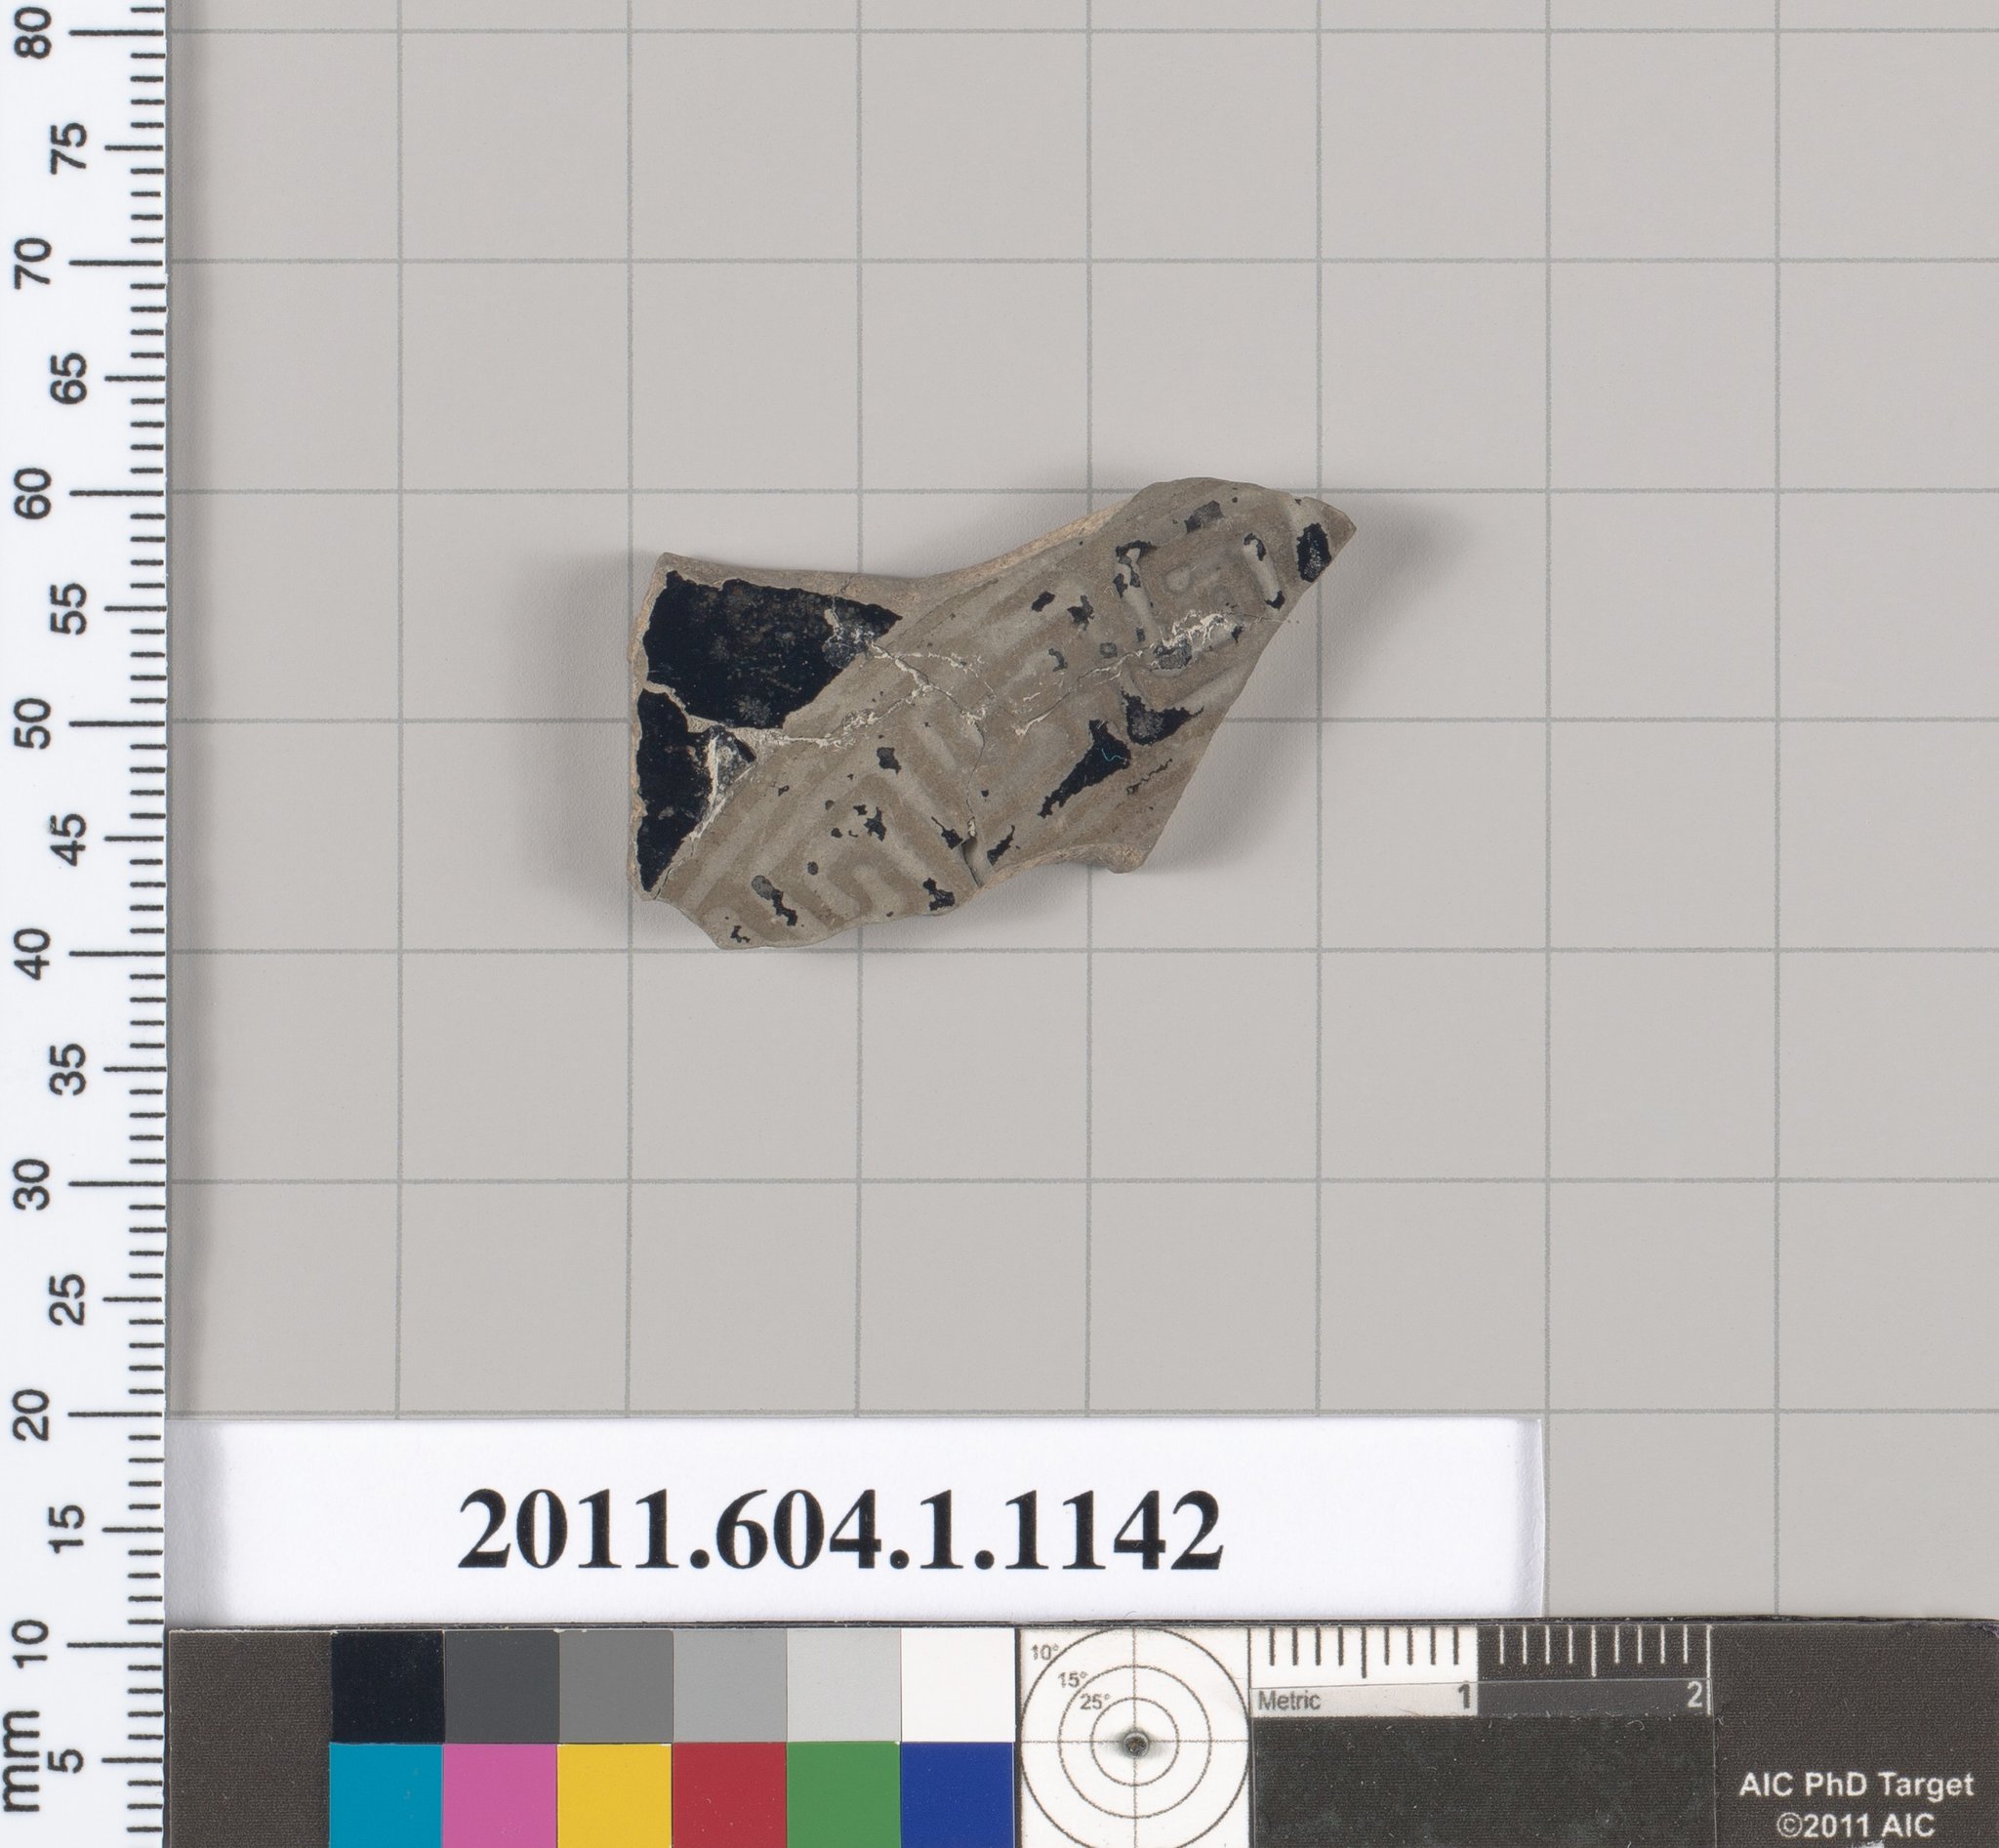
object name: kylix fragment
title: Terracotta fragment of a kylix (drinking cup)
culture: greek, attic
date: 475-451 BCE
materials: terracotta